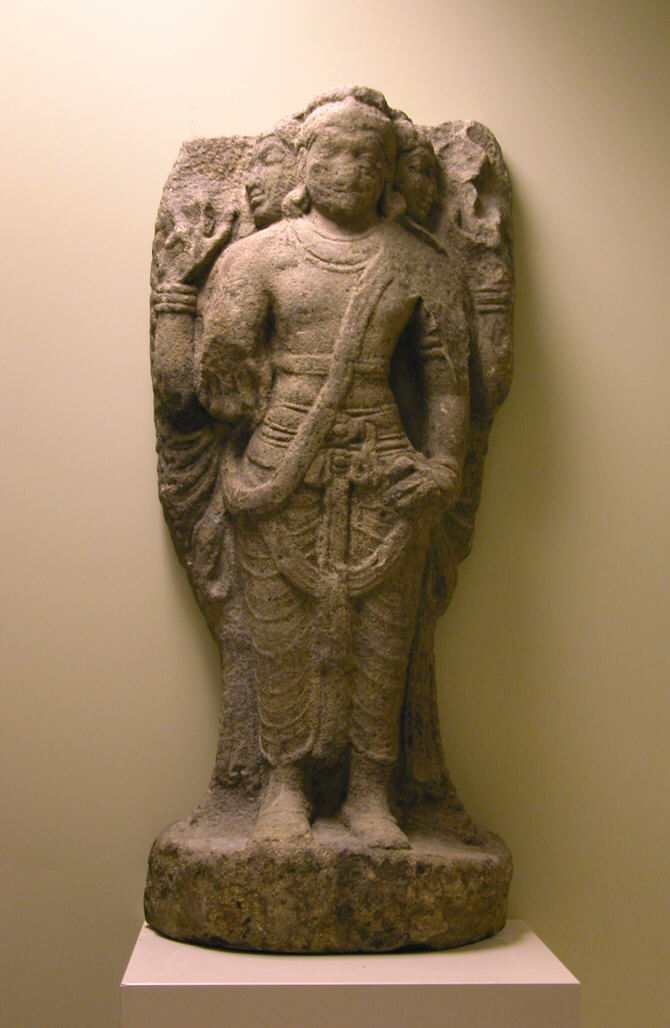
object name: figure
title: Standing Brahma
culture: india, south india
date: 901-1100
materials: granite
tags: brahma,hinduism